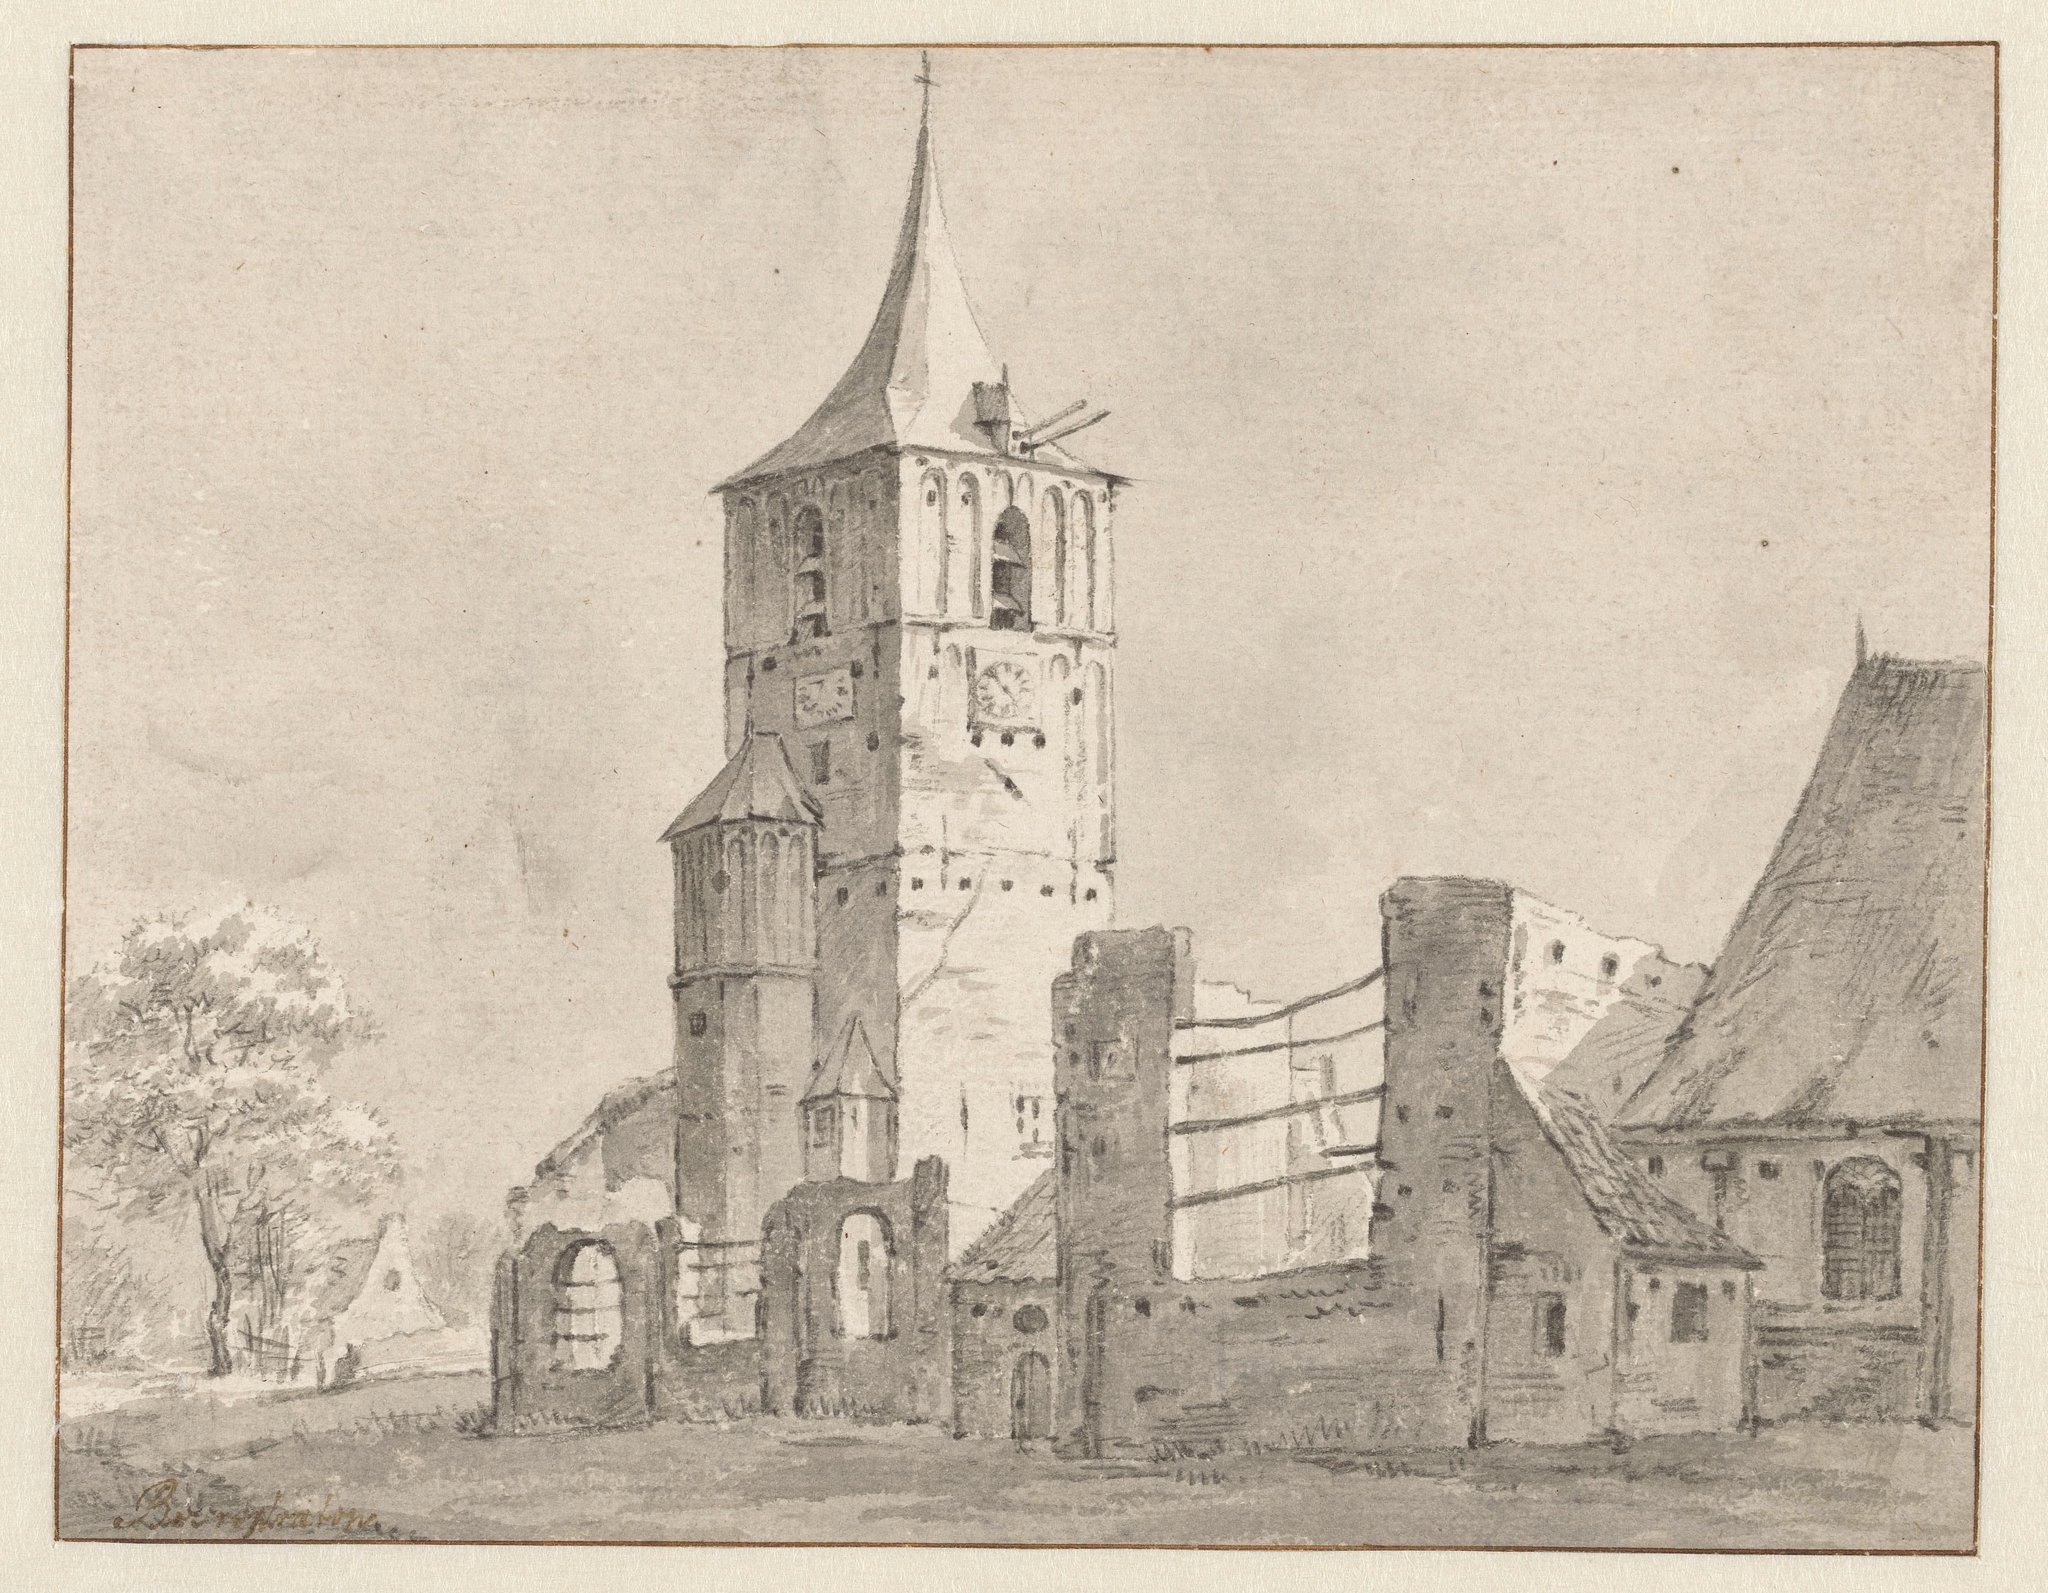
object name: drawing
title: Kerk te Warmond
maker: jan abrahamsz. beerstraten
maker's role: draughtsman, painter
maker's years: 1622-1666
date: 1600-1699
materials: chalk, paper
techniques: brush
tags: church (exterior), warmond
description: De kerk te Warmond, gedeeltelijk in ruïne; rechts is een gedeelte van het nieuwe kerkgebouw zichtbaar. In de verte links een hoge boom en een huis.